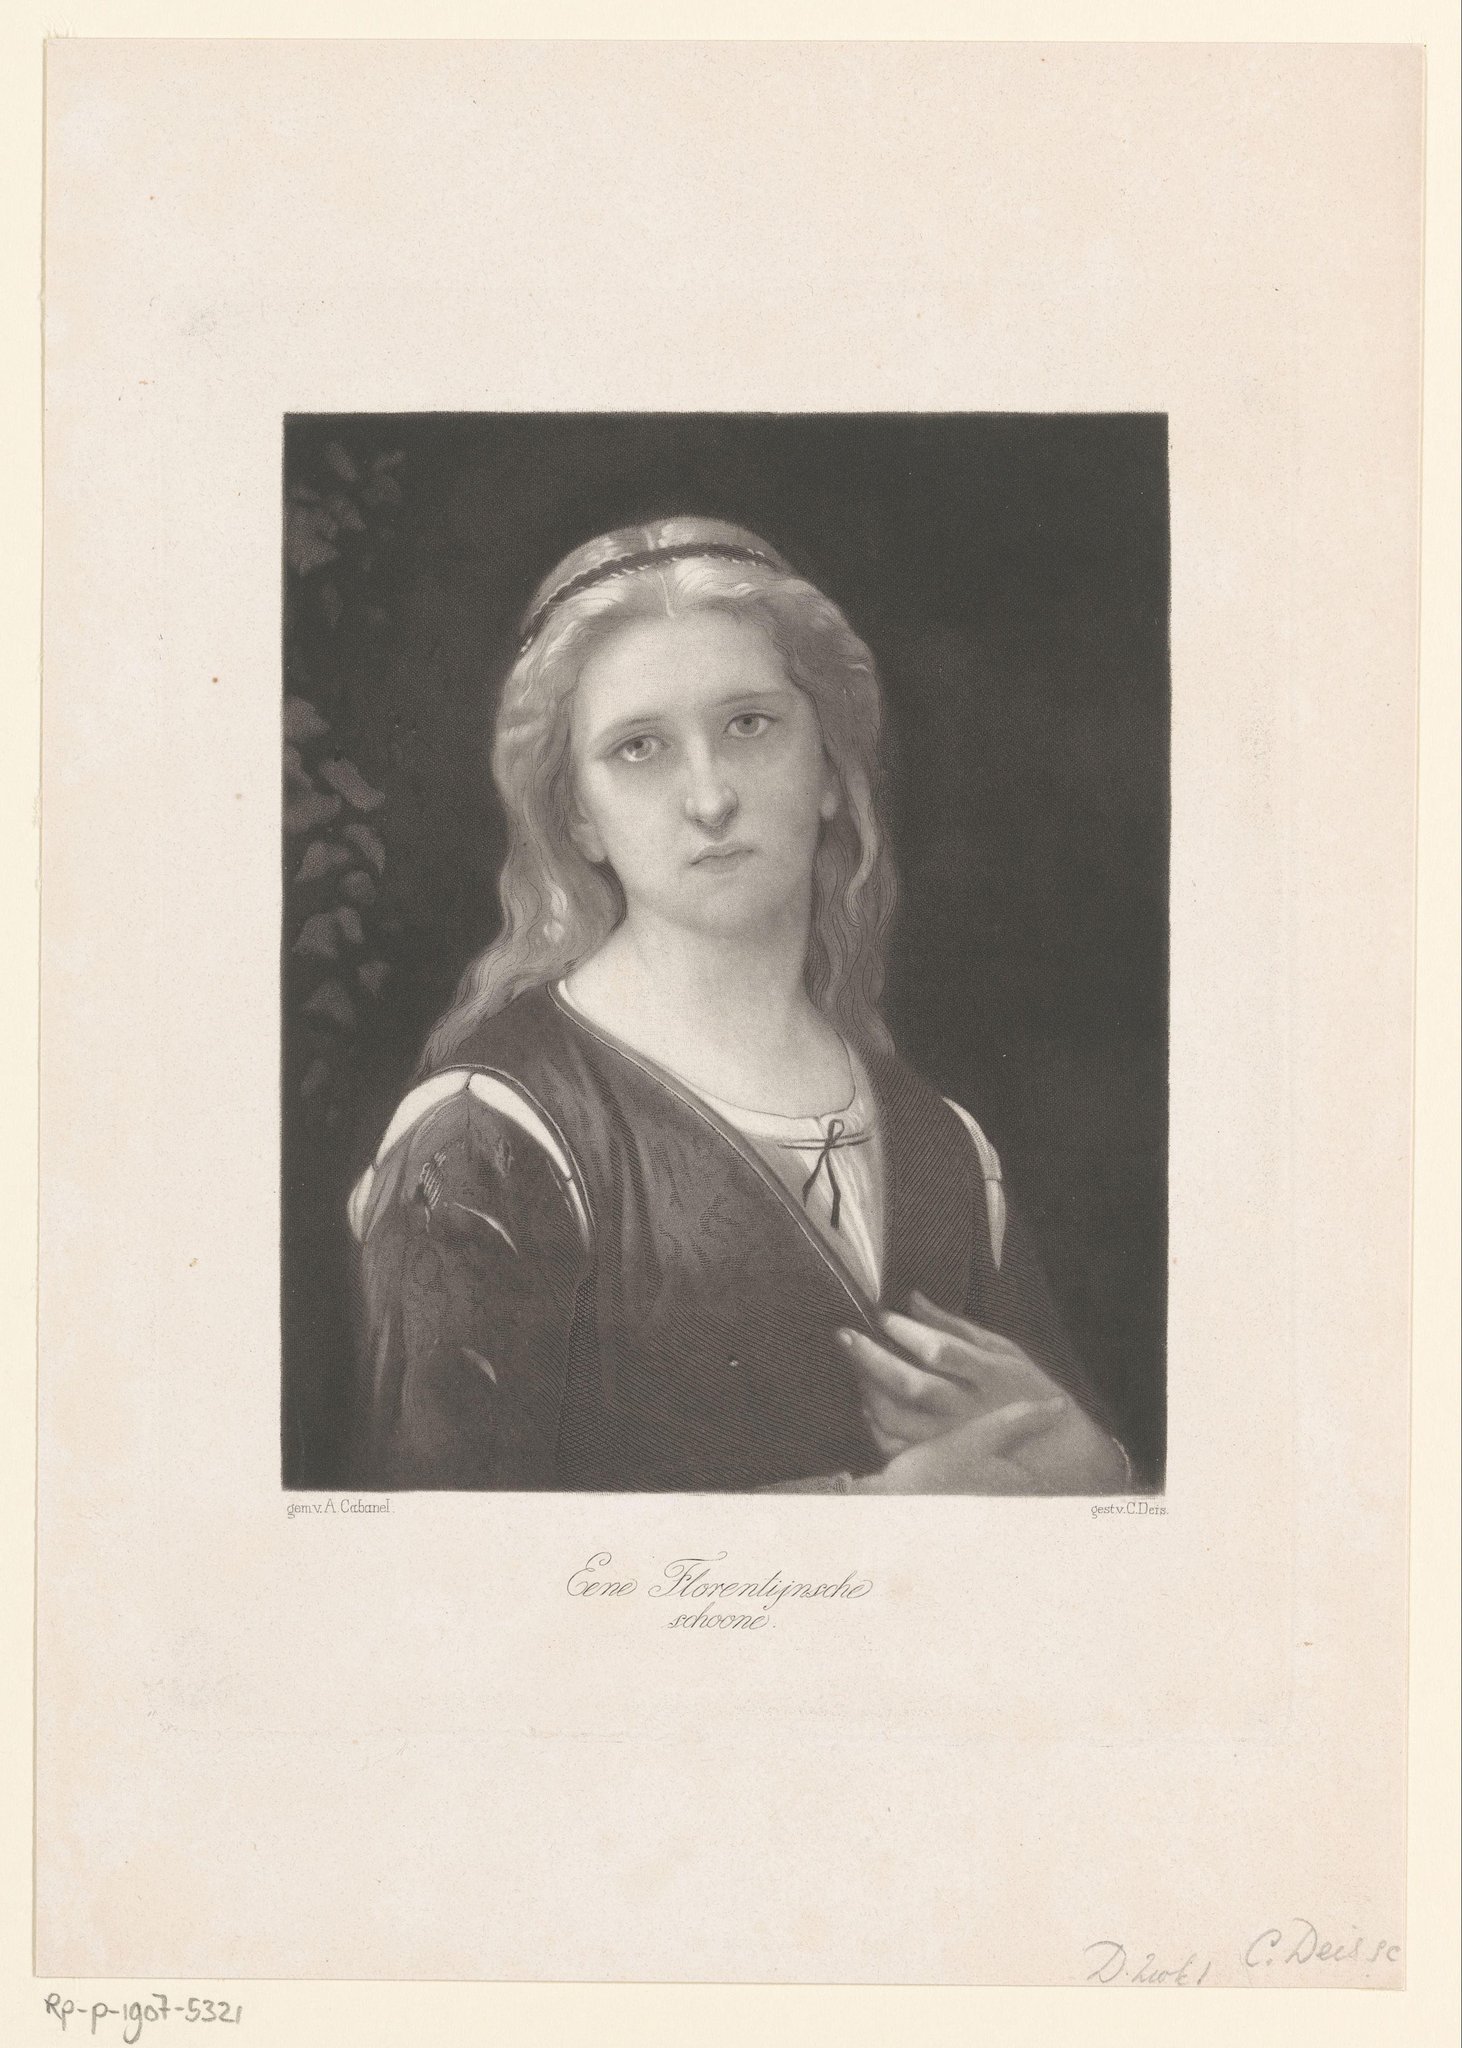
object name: print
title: Jonge Florentijnse vrouw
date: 1833-1884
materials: paper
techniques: etching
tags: adolescent, young woman, maiden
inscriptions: collector's mark: Lugt 2228